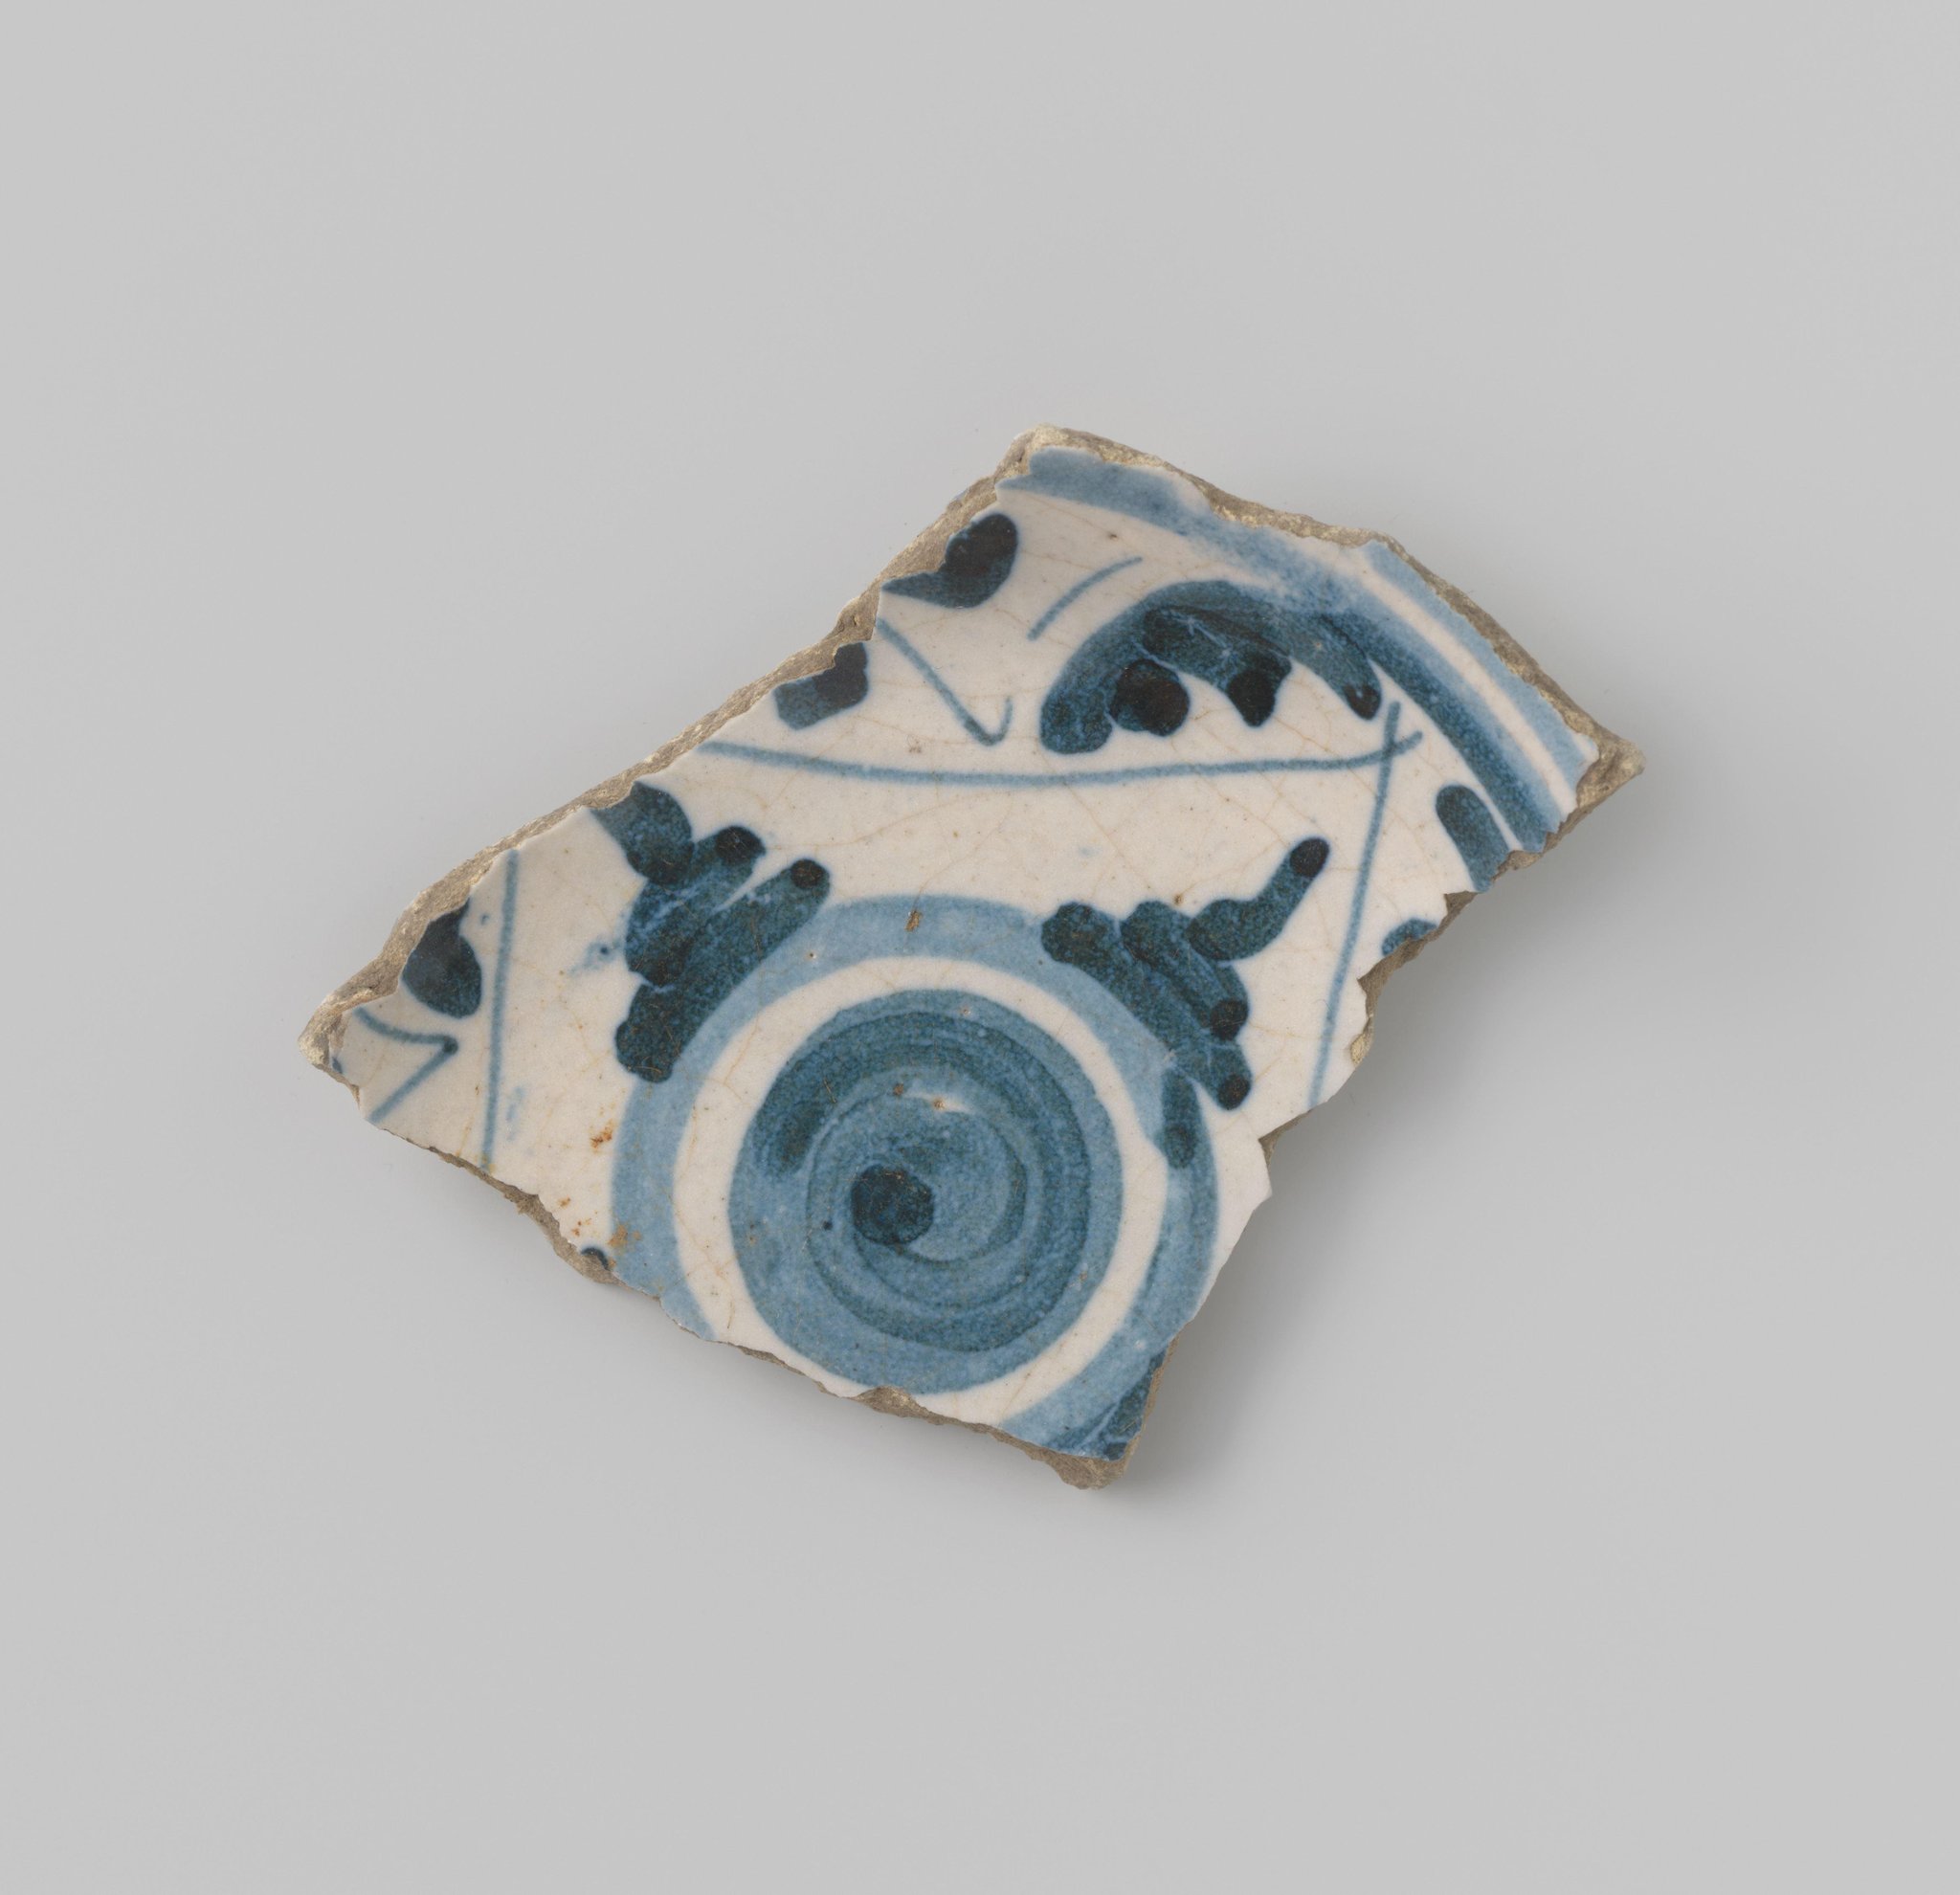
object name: fragment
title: Schotelscherf van witbakkend aardewerk, voorzien van wit glazuur aan de boven- en onderzijde, waarbij op de bovenzijde een decoratie in geometrische vormen in blauw en op de onderzijde strepen in blauw zijn geschilderd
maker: Anonymous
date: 1500-1699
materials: earthenware, glaze